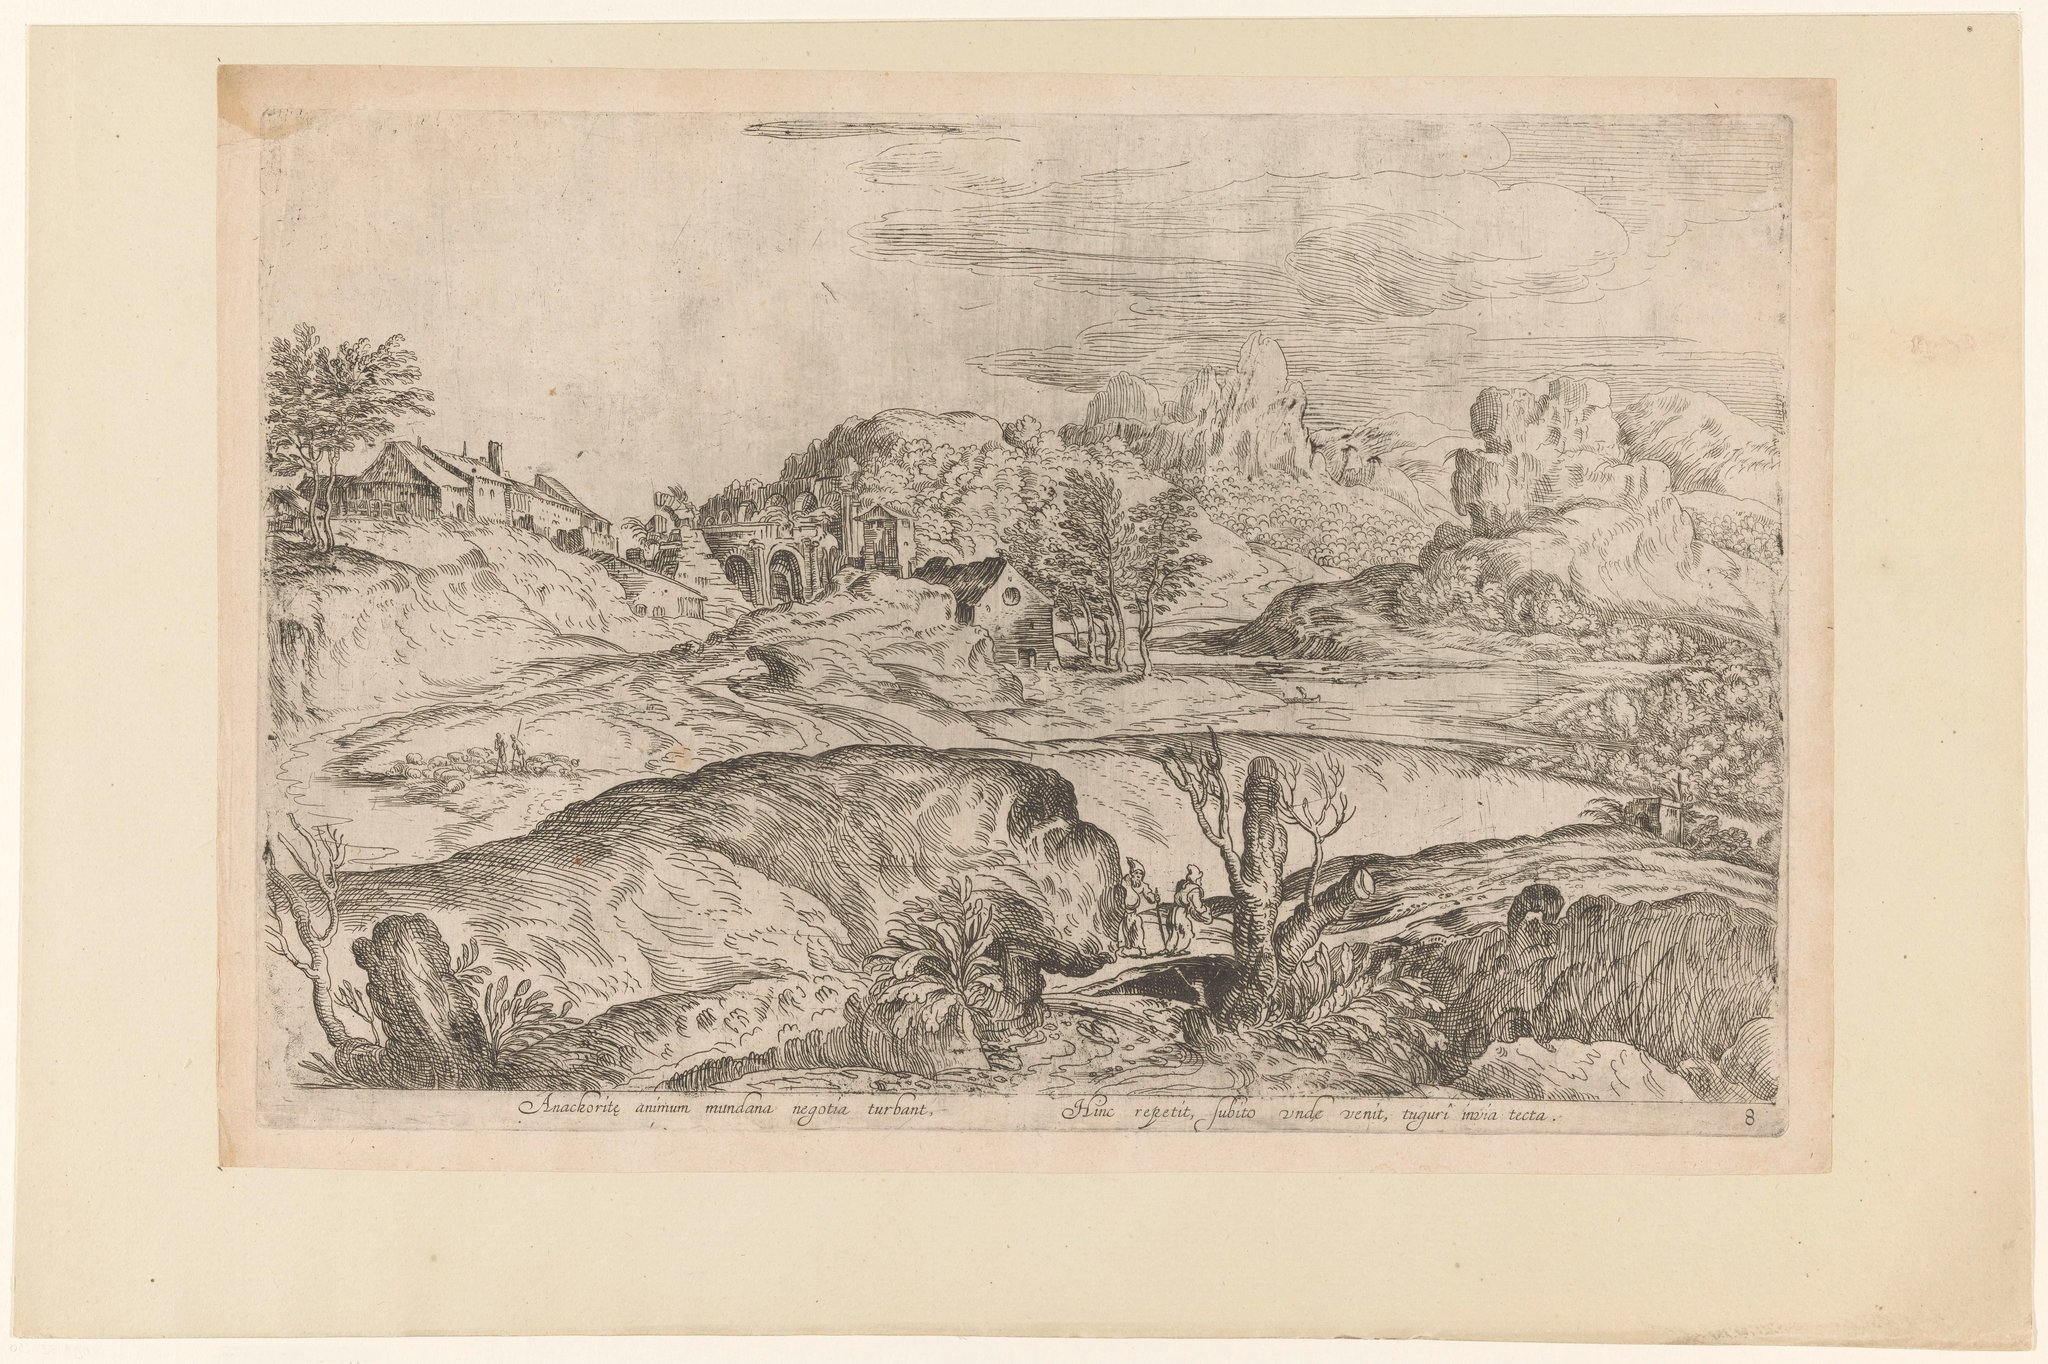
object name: print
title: Landschappen naar Domenico Campagnola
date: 1600-1699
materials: paper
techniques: etching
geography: italy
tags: landscapes, pilgrim(s), pilgrimage, pilgrim(s) under way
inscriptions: collector's mark: Lugt 2228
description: Heuvellandschap met links een dorp. Op de voorgrond rechts twee pelgrims. Titel in het Latijn in ondermarge. Genummerd rechtsonder: 8.